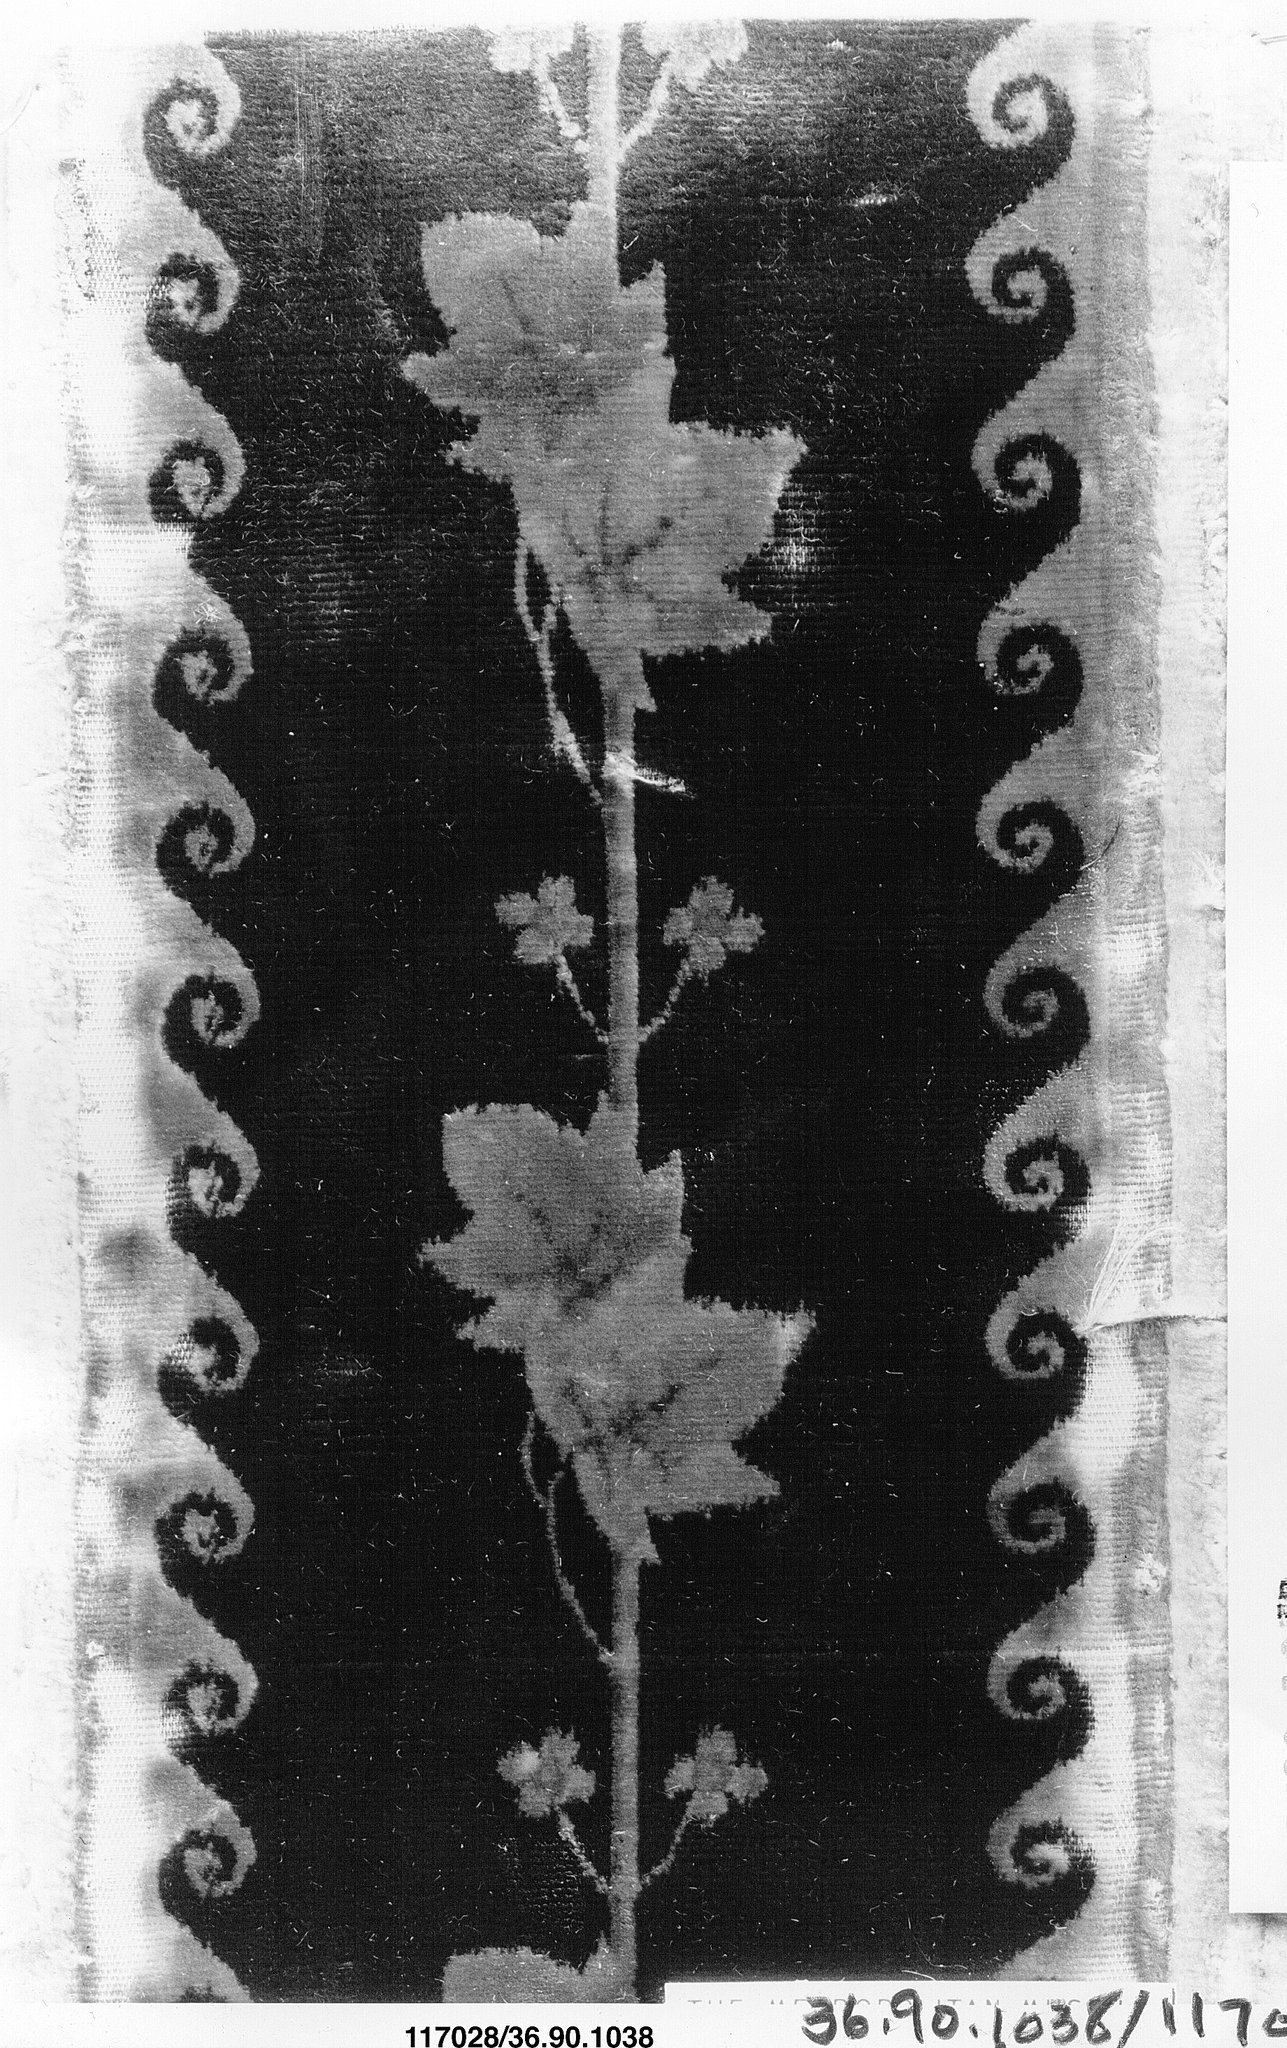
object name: border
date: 1801-1900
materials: silk